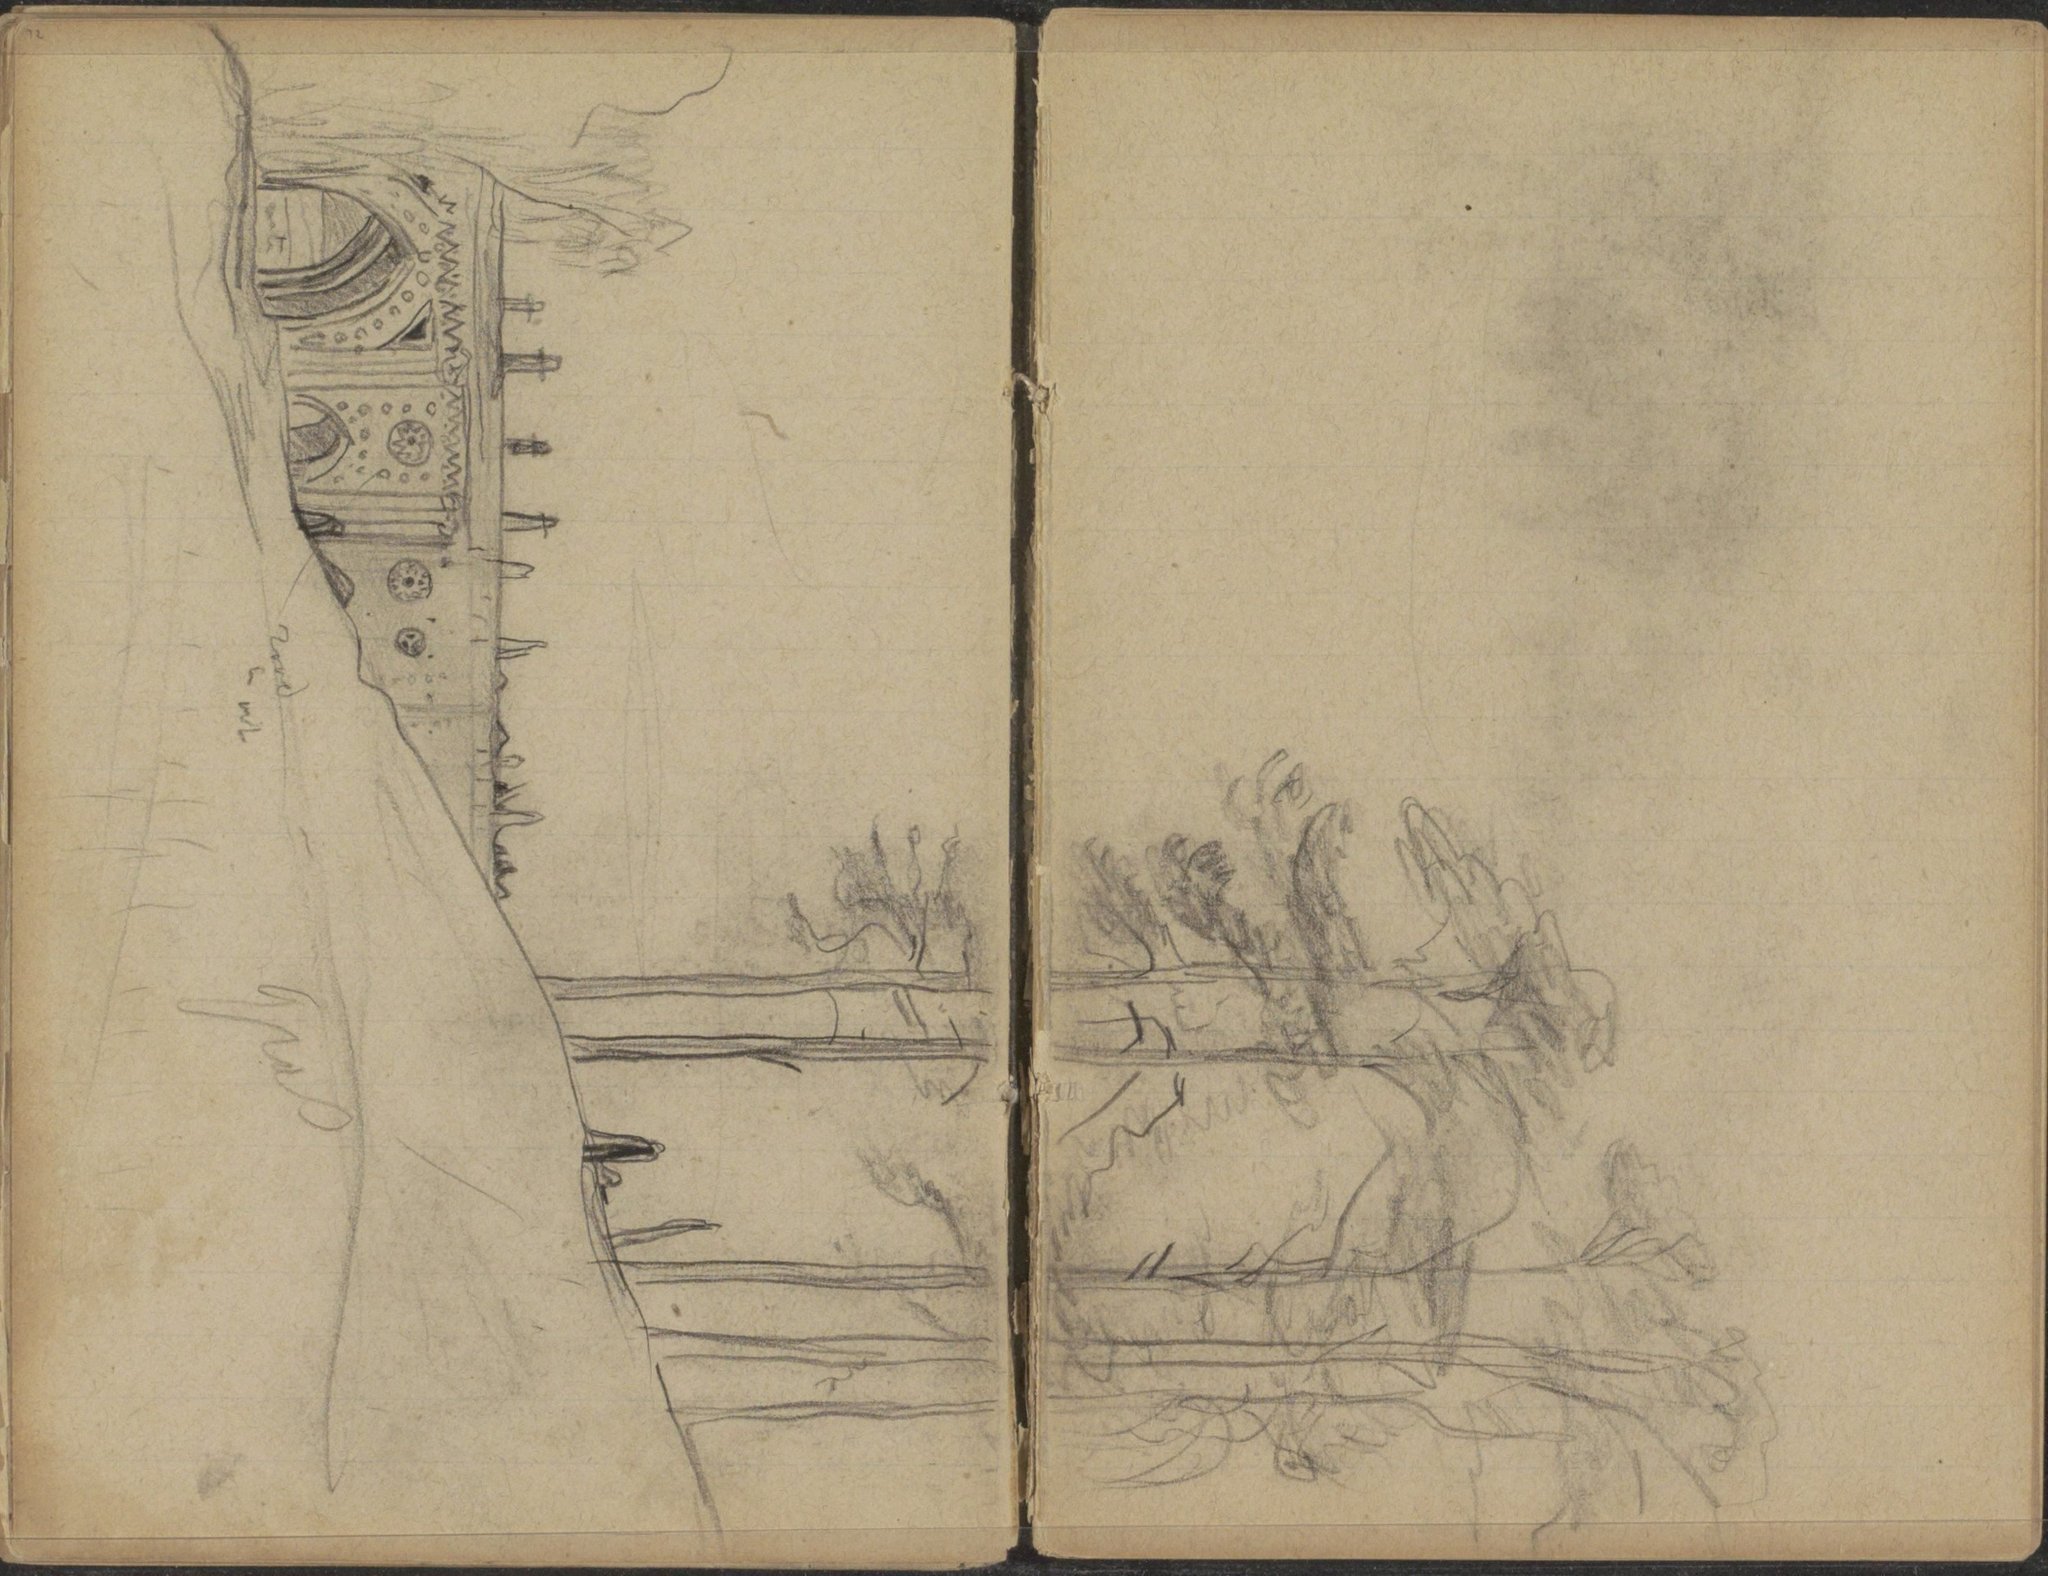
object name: sketchbook leaf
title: Poort bij hoge bomen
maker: marius bauer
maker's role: draughtsman, print maker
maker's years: 1867-1932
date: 1896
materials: chalk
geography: russia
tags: trees, arch, archivolt ~ architecture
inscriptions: annotation: ‘gras’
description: Bauer legde de poort vanuit een ander aanzicht vast in zijn krijttekening 'Poort in Rusland' (zie documentatie).